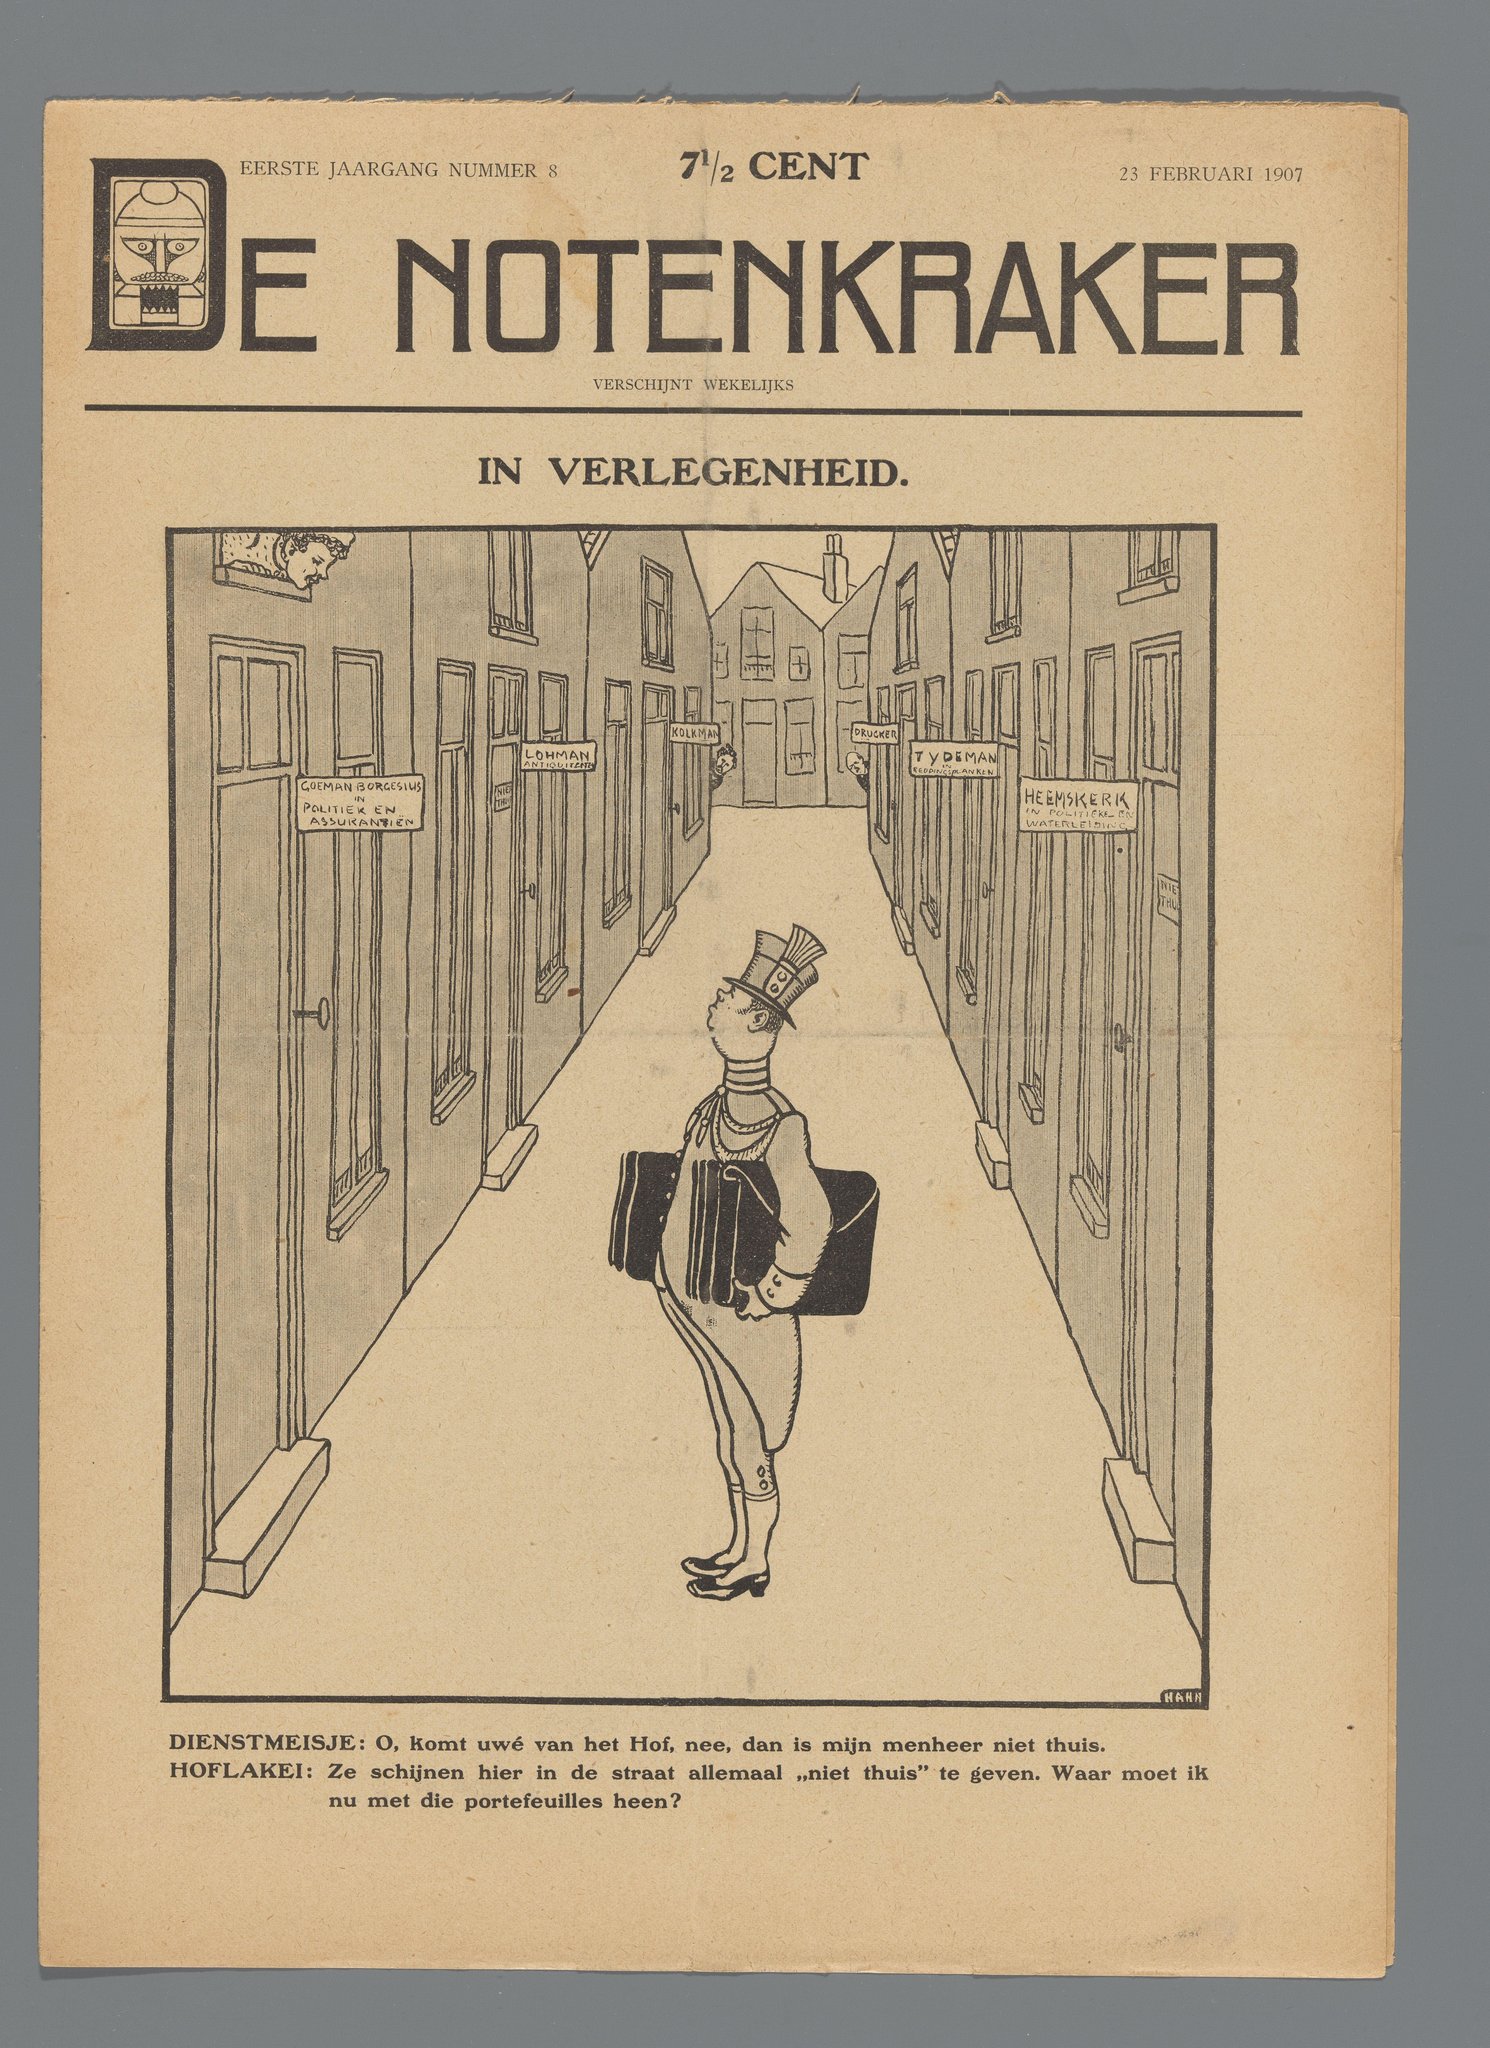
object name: print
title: De Notenkraker, 23 februari 1907 / In verlegenheid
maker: albert hahn (i)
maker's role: draughtsman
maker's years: 1877-1918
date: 1907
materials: paper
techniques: lithograph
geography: amsterdam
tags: minister ~ government, political caricatures and satires, netherlands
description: Aflevering van het satirische tijdschrift De Notenkraker van 23 februari 1907, eerste jaargang, nummer 8. Omslag met illustratie met een lakei van het hof die ministerportefeuilles wil bezorgen maar niemand geeft thuis. Onderdeel van een volledige eerste jaargang (1907). Elk nummer bevat 8 bladzijden, deels nog niet losgesneden, met op de voorzijde steeds een spotprent van Albert Hahn, op de overige pagina's prenten van Hahn steeds tussen de tekst. In de letter 'D' van de titel is een kop van een zgn. notenkraker afgebeeld.